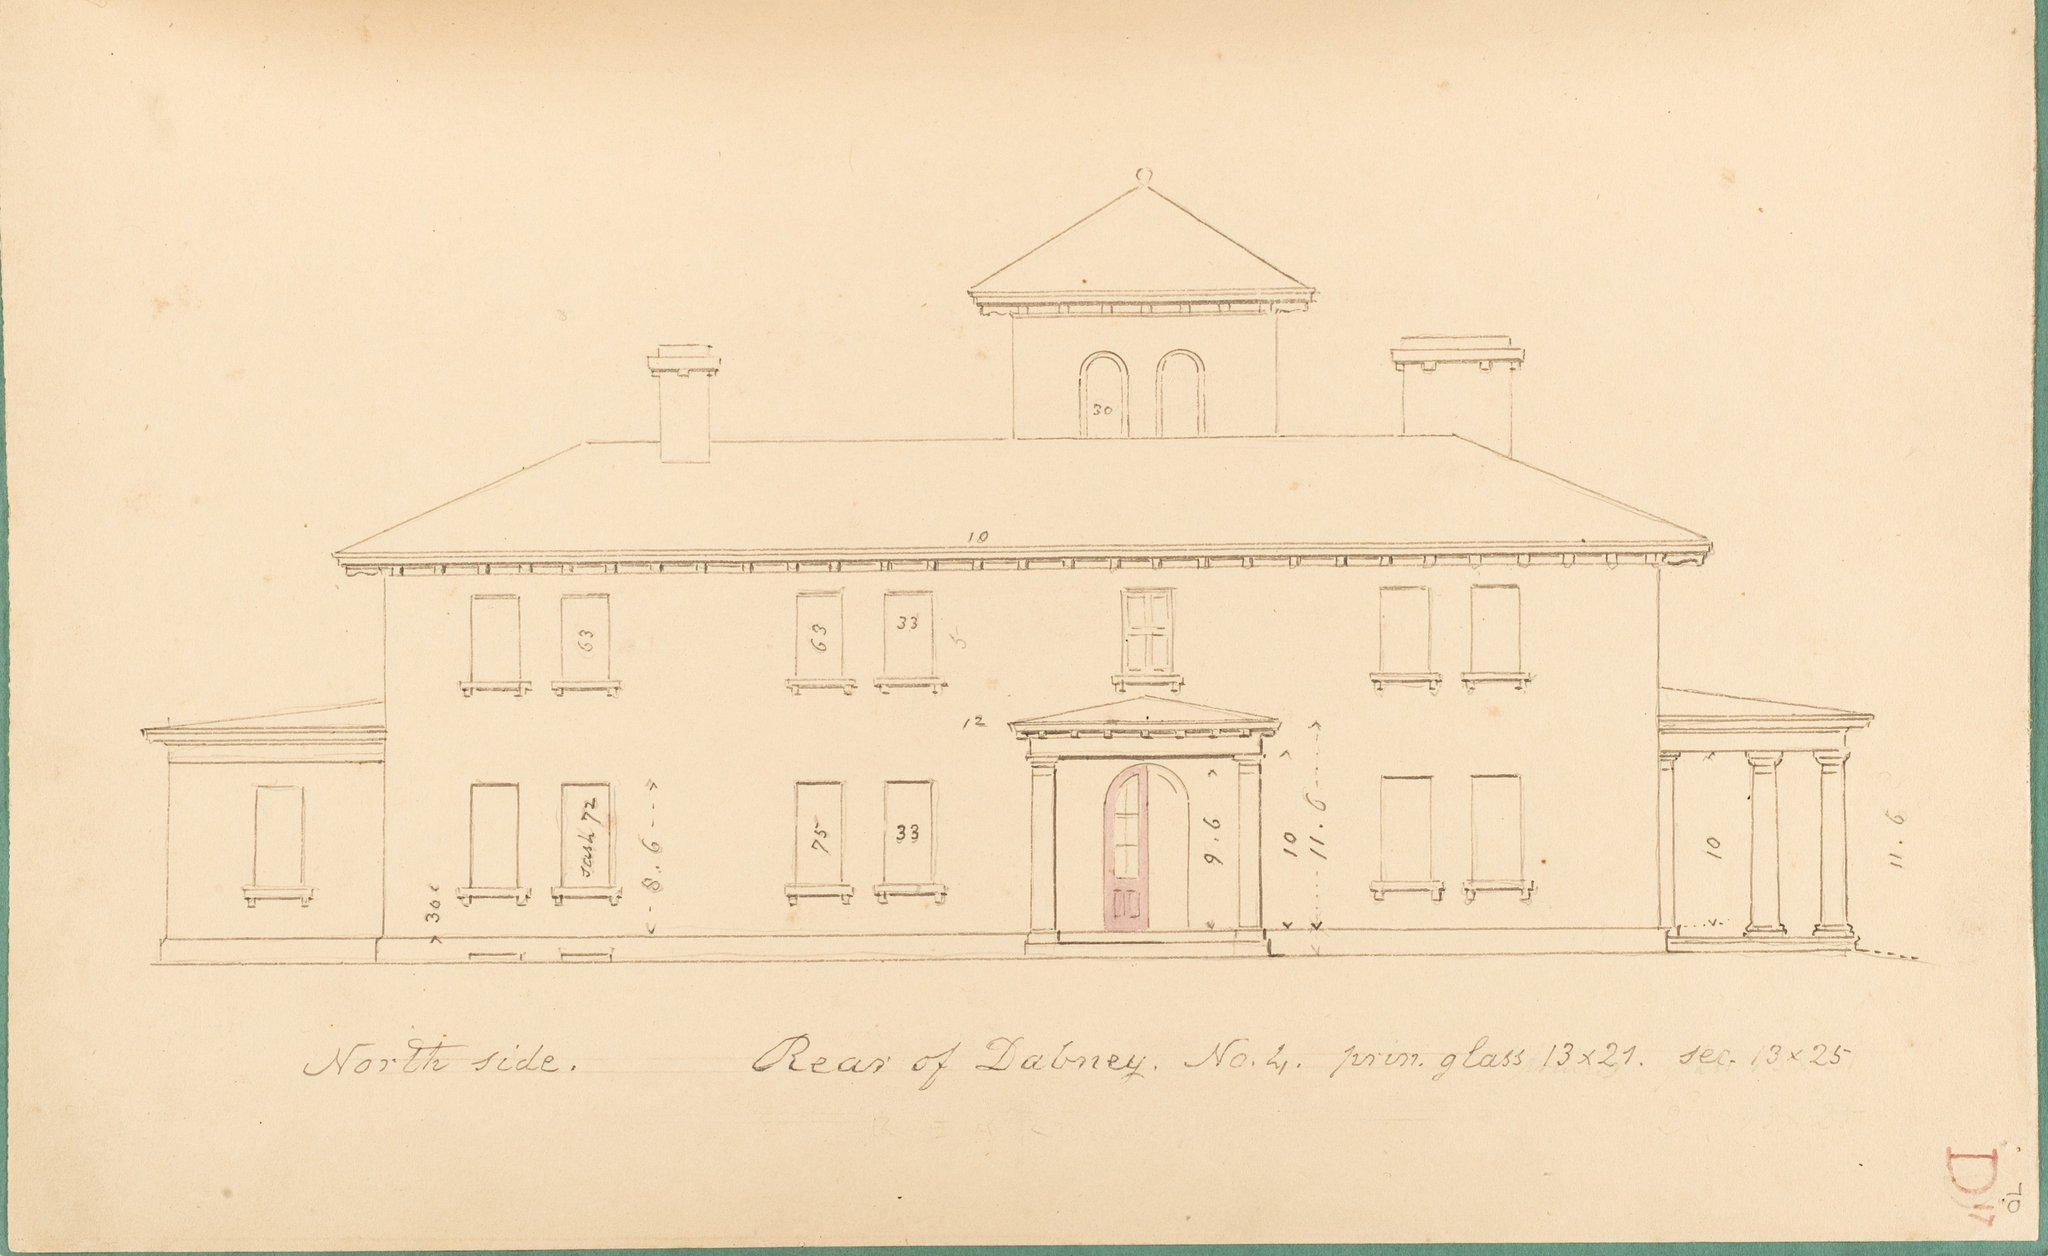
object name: drawing ornament architecture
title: House of R. Dabney, Powhatan, Virginia (north [rear] side)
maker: alexander jackson davis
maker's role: artist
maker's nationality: american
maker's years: 1803-1892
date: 1858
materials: ink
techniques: wash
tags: houses